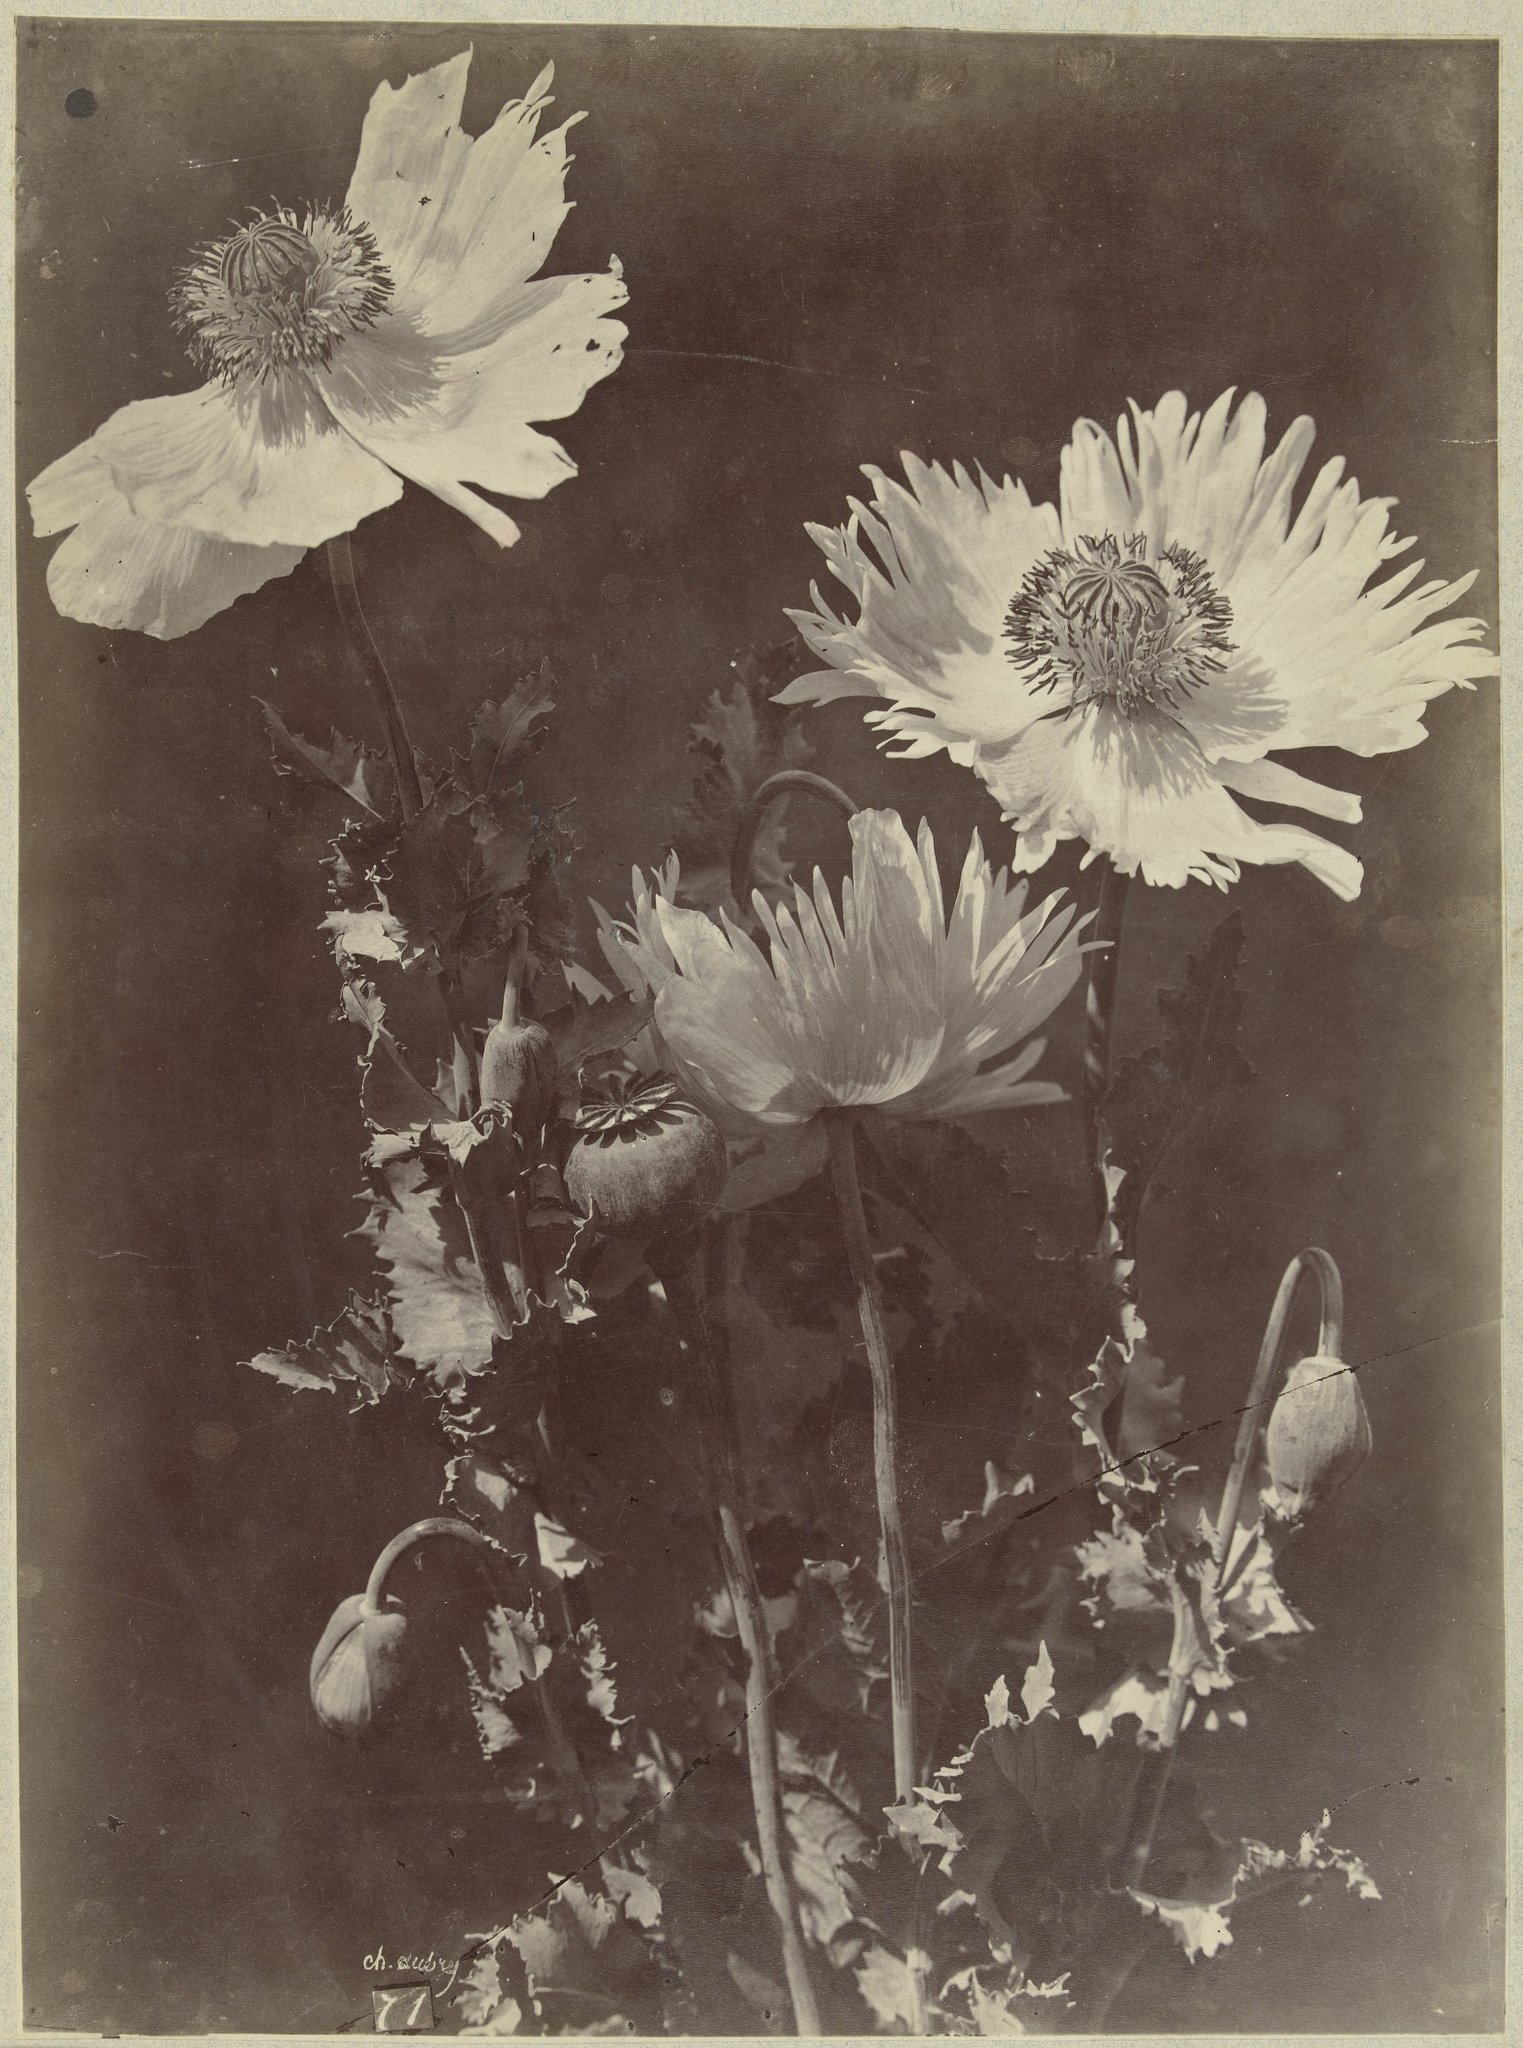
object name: photograph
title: Bloemstilleven met papavers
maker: charles aubry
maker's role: fotograaf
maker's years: 1811-1877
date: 1864-1872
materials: cardboard, paper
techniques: albumen print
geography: paris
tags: flowers: poppy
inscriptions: number: ‘71’, signature: ‘ch. aubry’